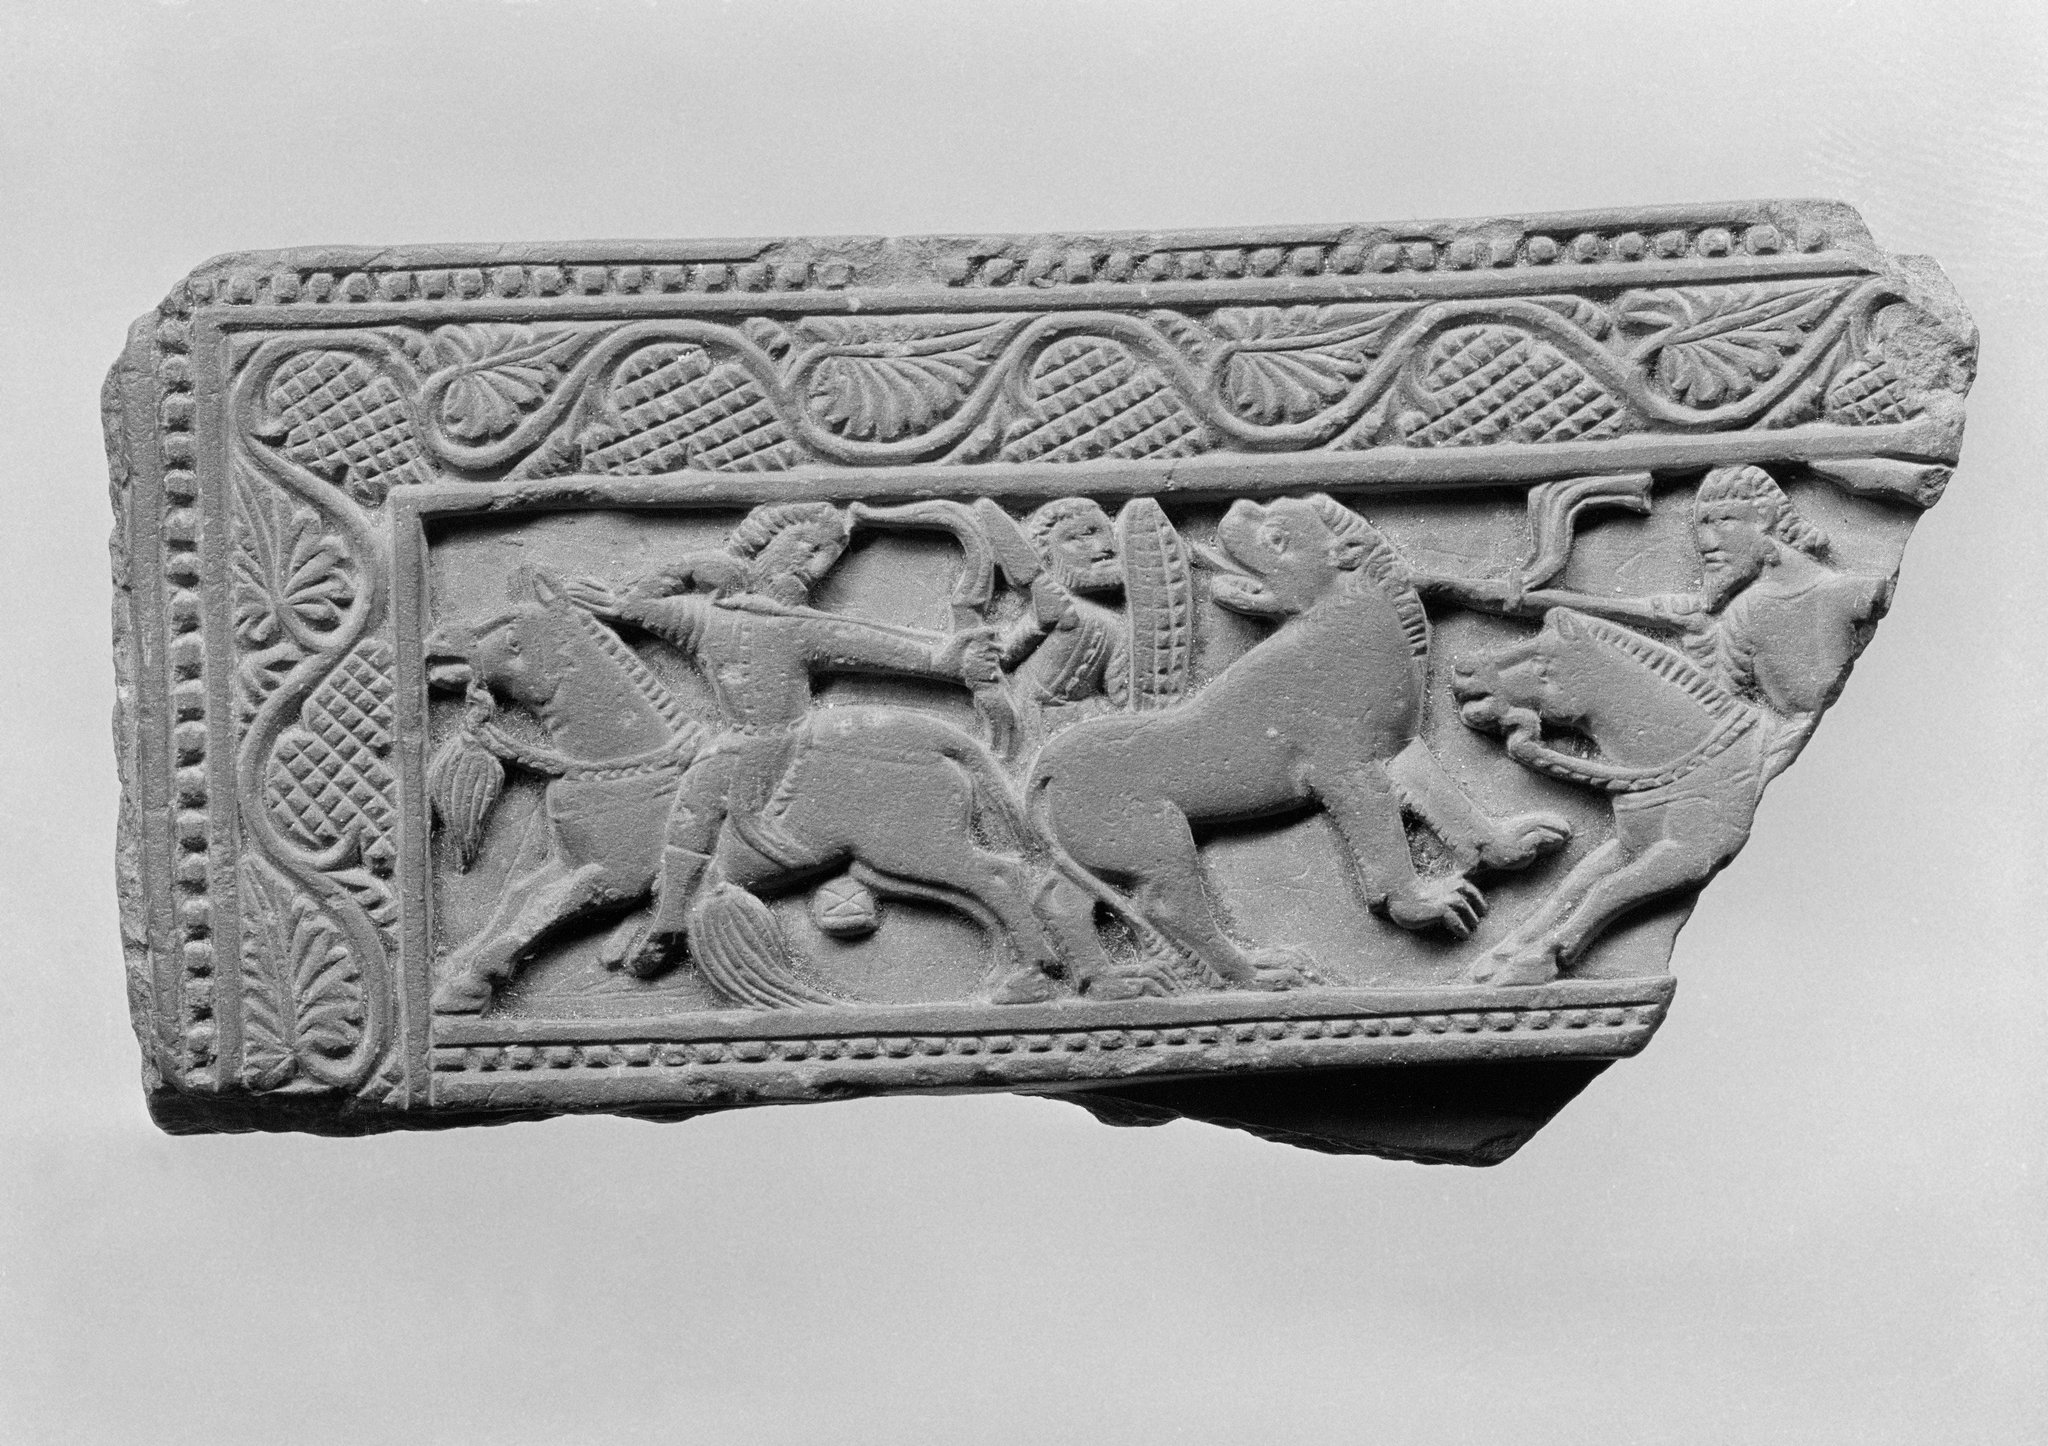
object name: lid fragment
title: Fragment of a Lid (?) with a Hunting Scene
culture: gandhara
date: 401-600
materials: stone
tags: animals,gandhara,hunting